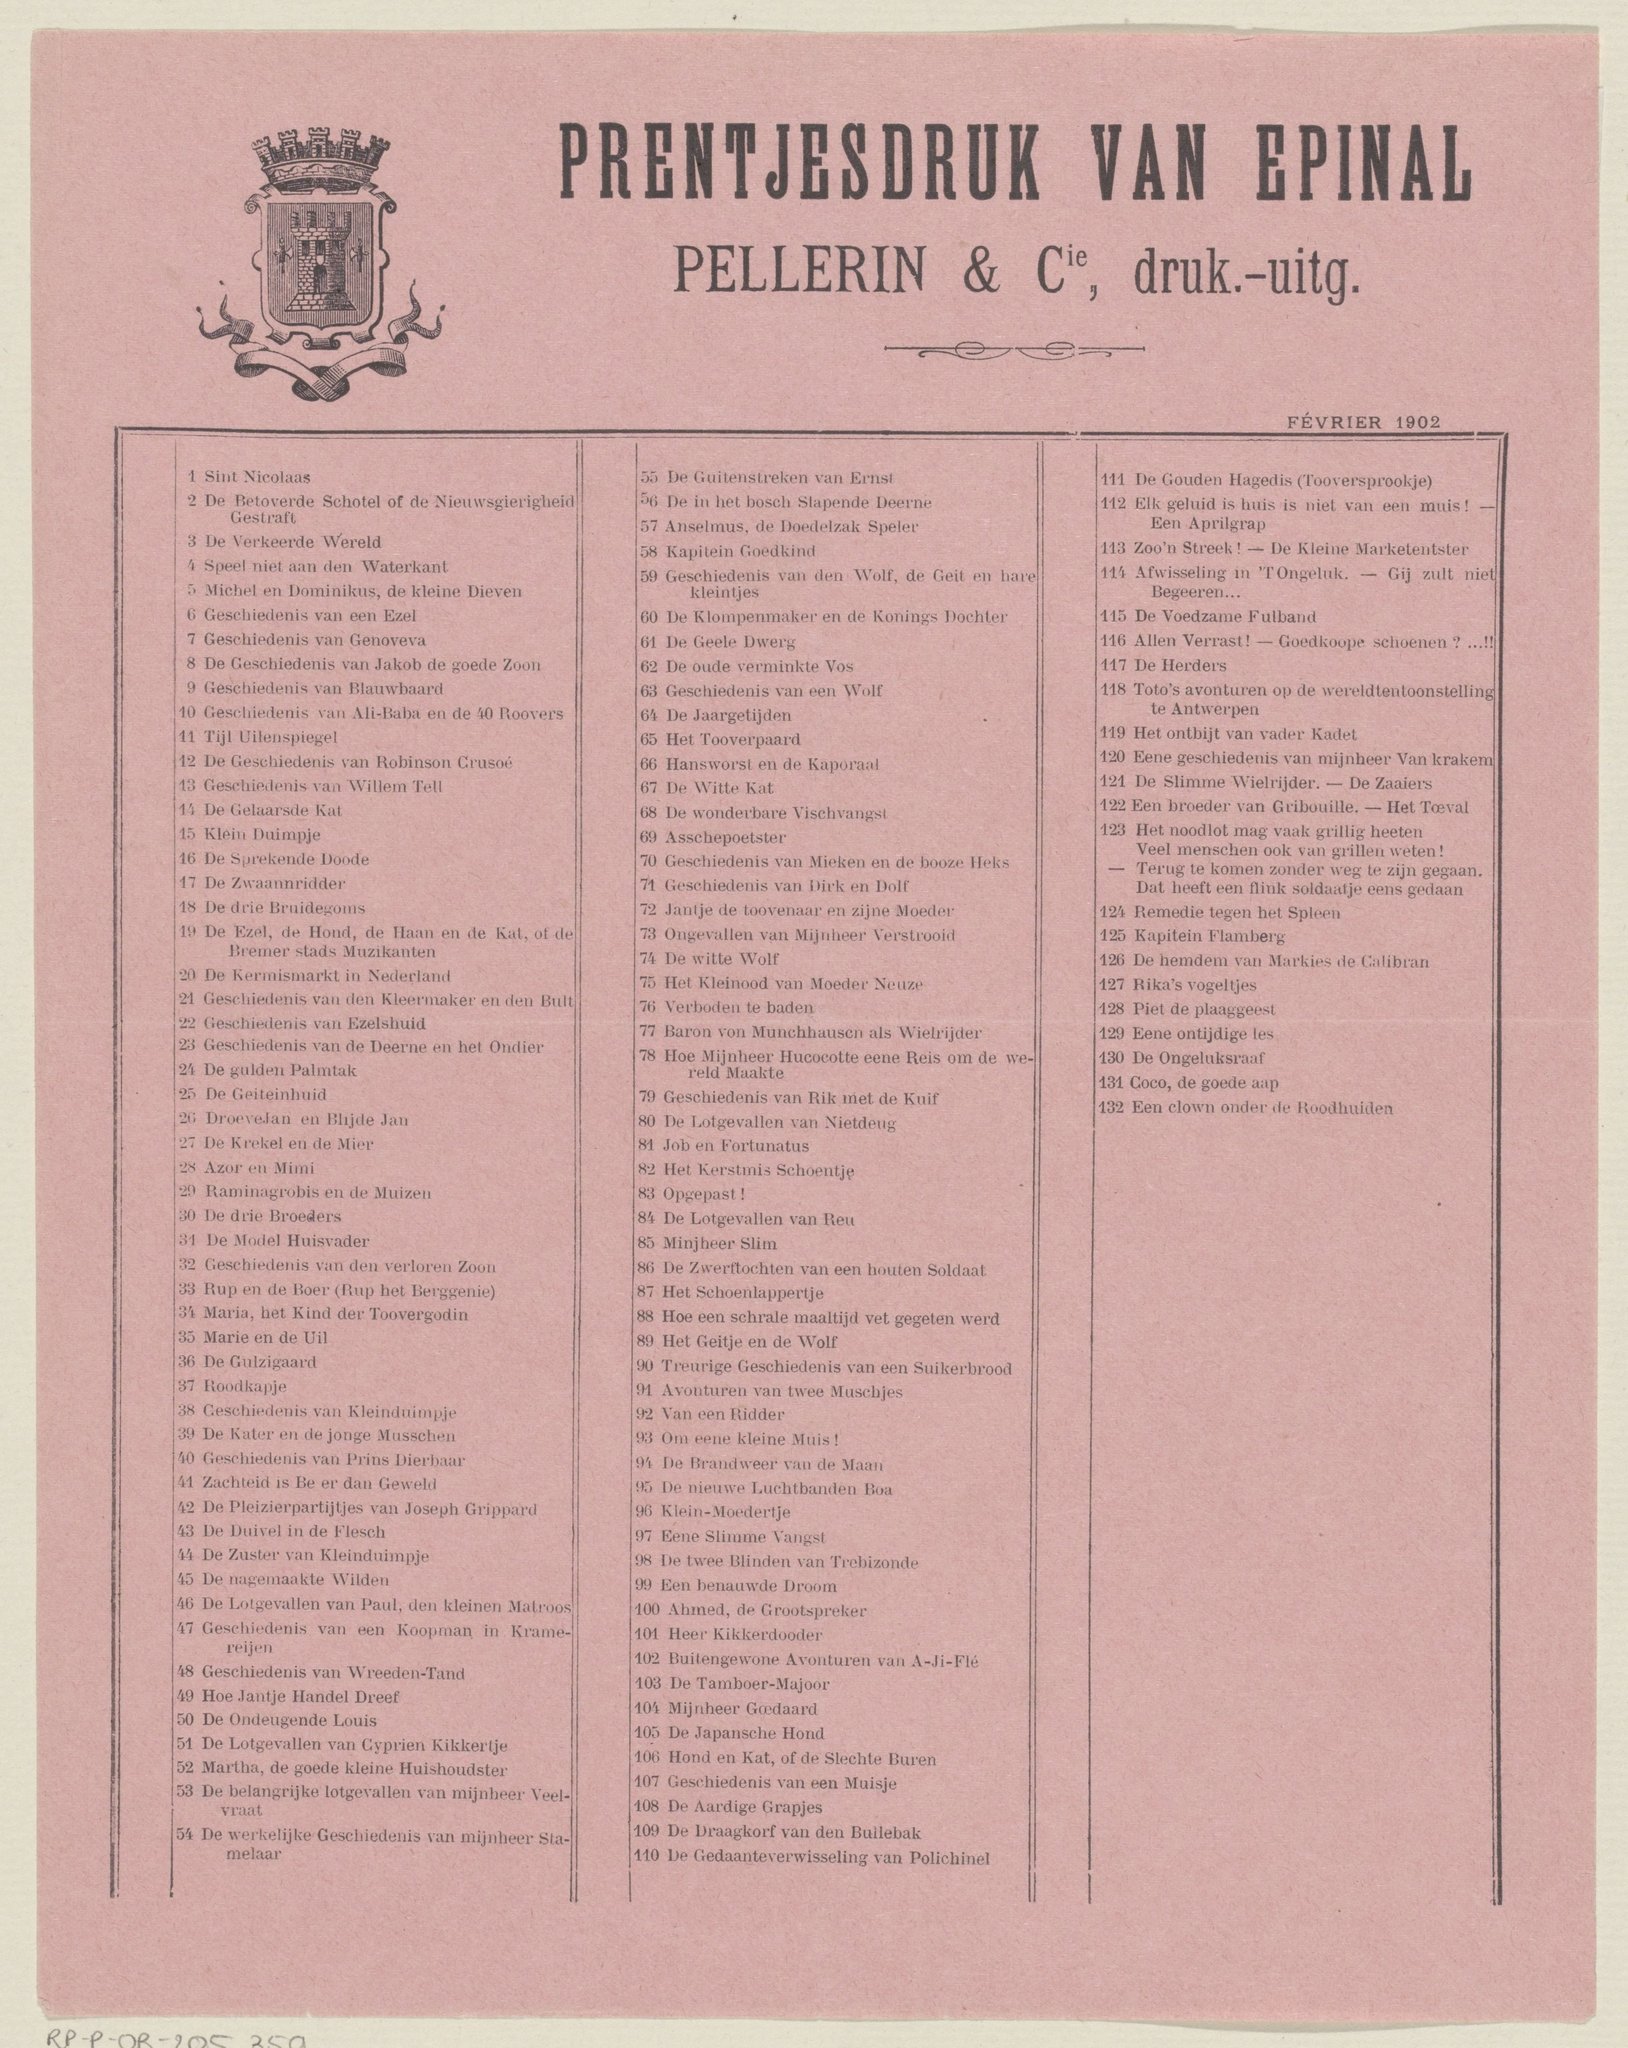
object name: fondslijst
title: Fondslijst Pellerin & Cie.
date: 1902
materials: paper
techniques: letterpress printing, lithograph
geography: epinal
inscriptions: collector's mark: Lugt 2760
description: Roze blad met de fondslijst van Pellerin & Cie. te Epinal, gedateerd februari 1902. Op de lijst worden 132 prenten genoemd.